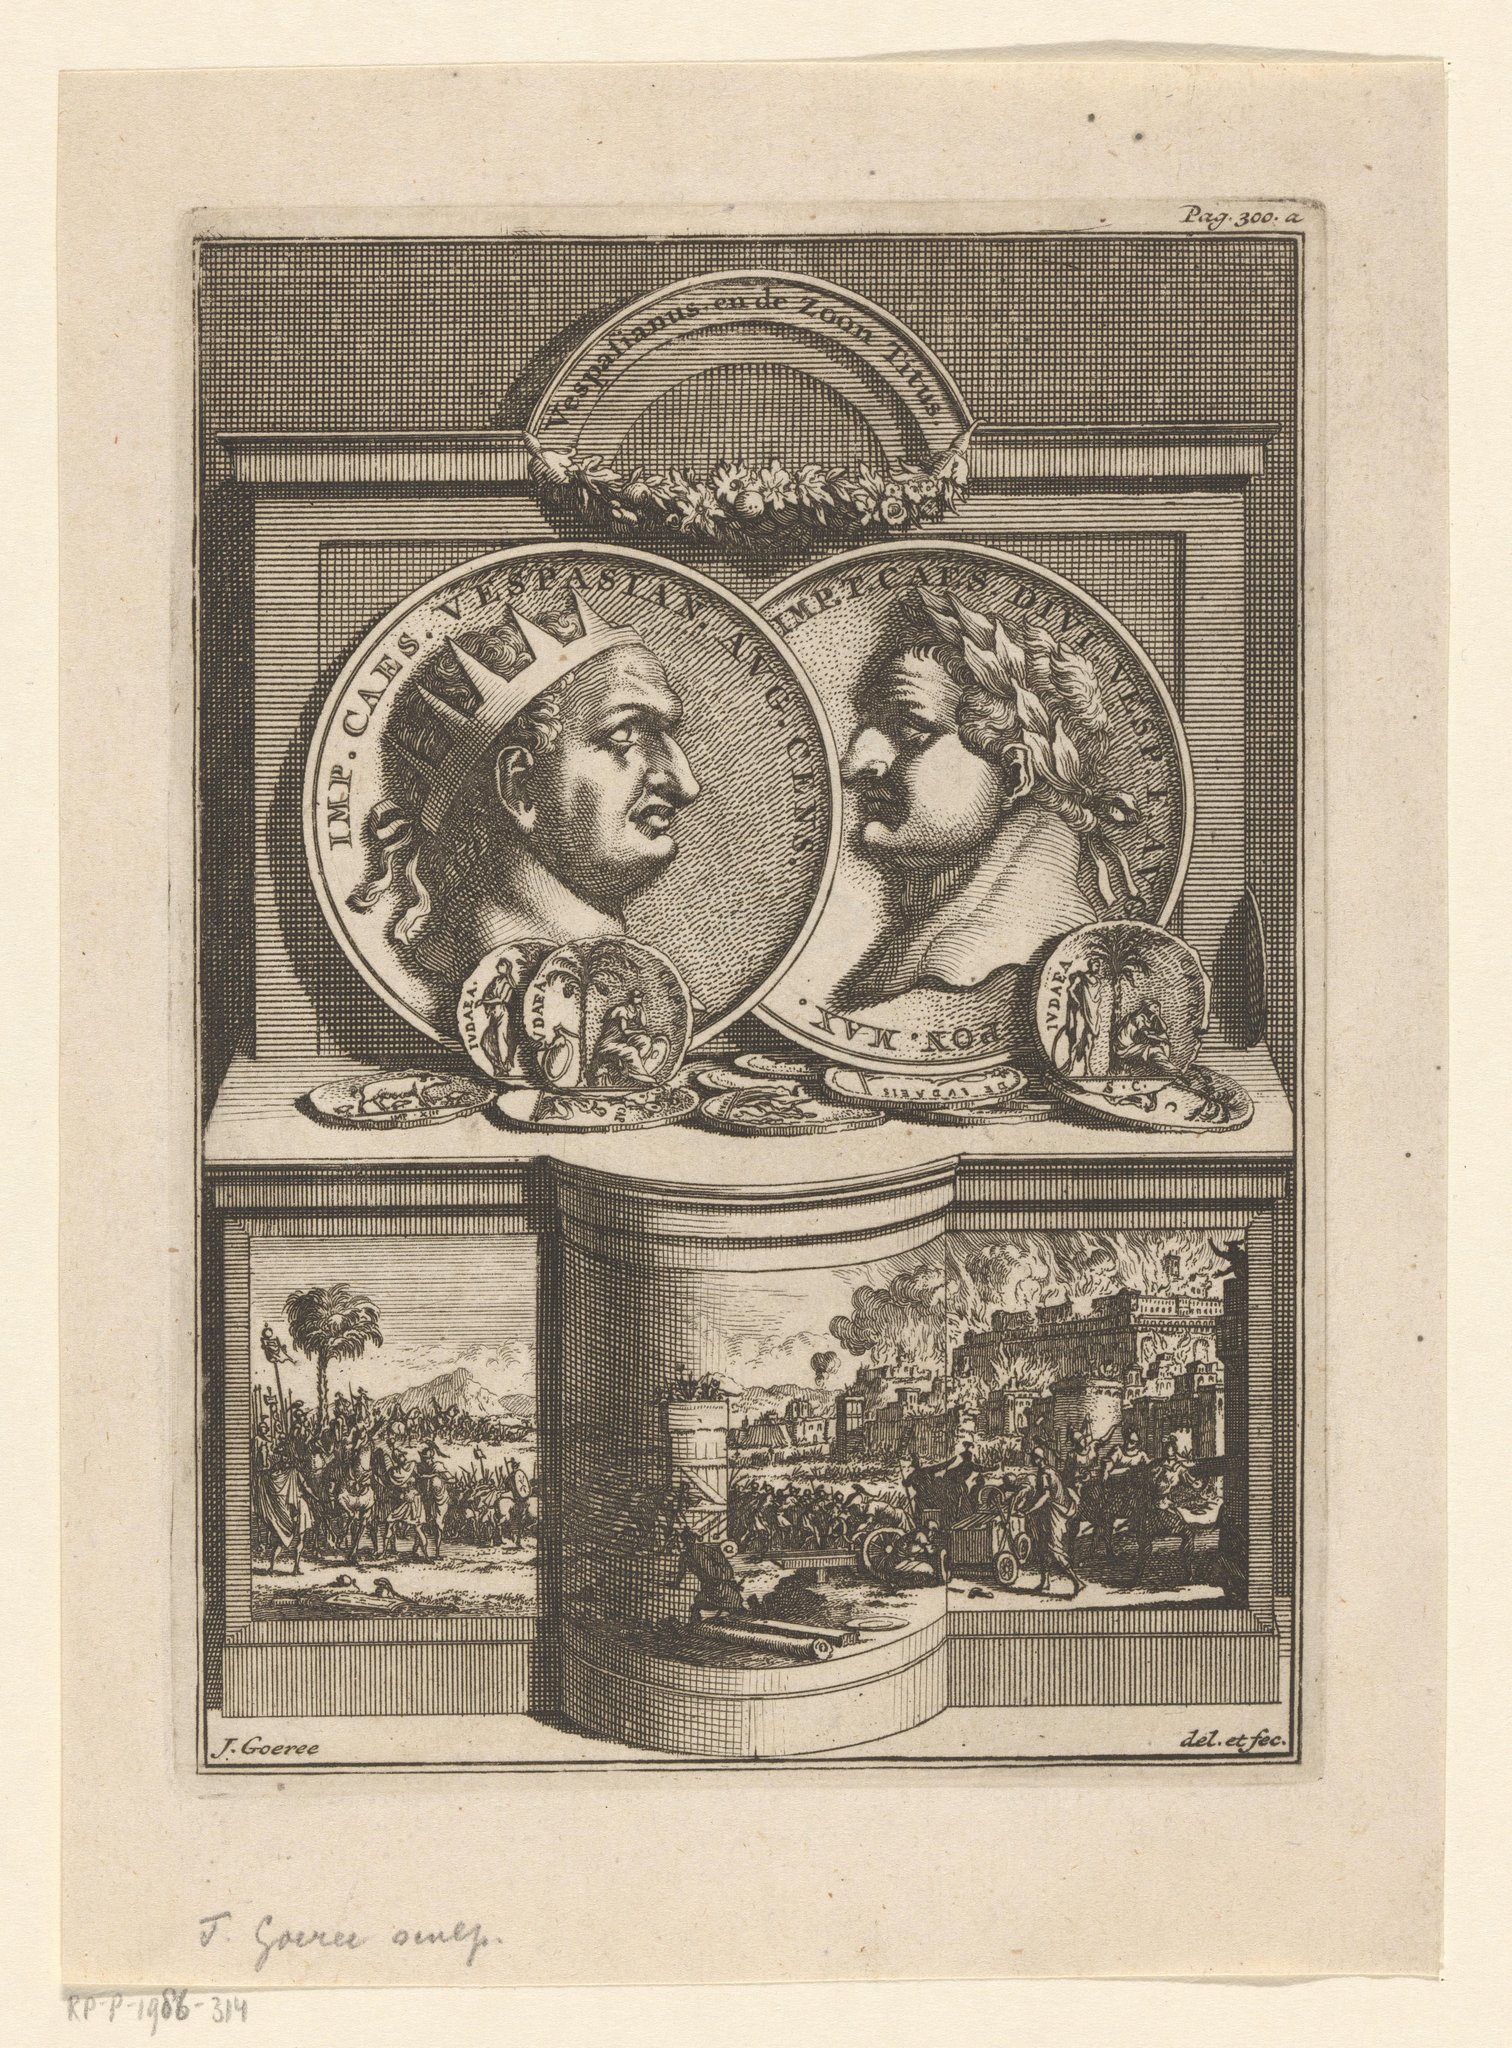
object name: book illustration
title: Vespasianus en de Zoon Titus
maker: jan goeree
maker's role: draughtsman, print maker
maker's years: 1670-1731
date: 1730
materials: paper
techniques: etching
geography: northern netherlands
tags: historical persons, emperor, bombardment ~ siege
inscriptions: collector's mark: Lugt 2228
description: Prent waarschijnlijk uit: Goeree, Willem. De Kerklyke en Weereldlyke Historien; Uyt d'Aal-Ouwde Aardbeschryving (...). Leiden: Johannes van Abcoude, 1730, p. 300. Eerdere staat gebruikt in uitgave van dit boek uit 1705.